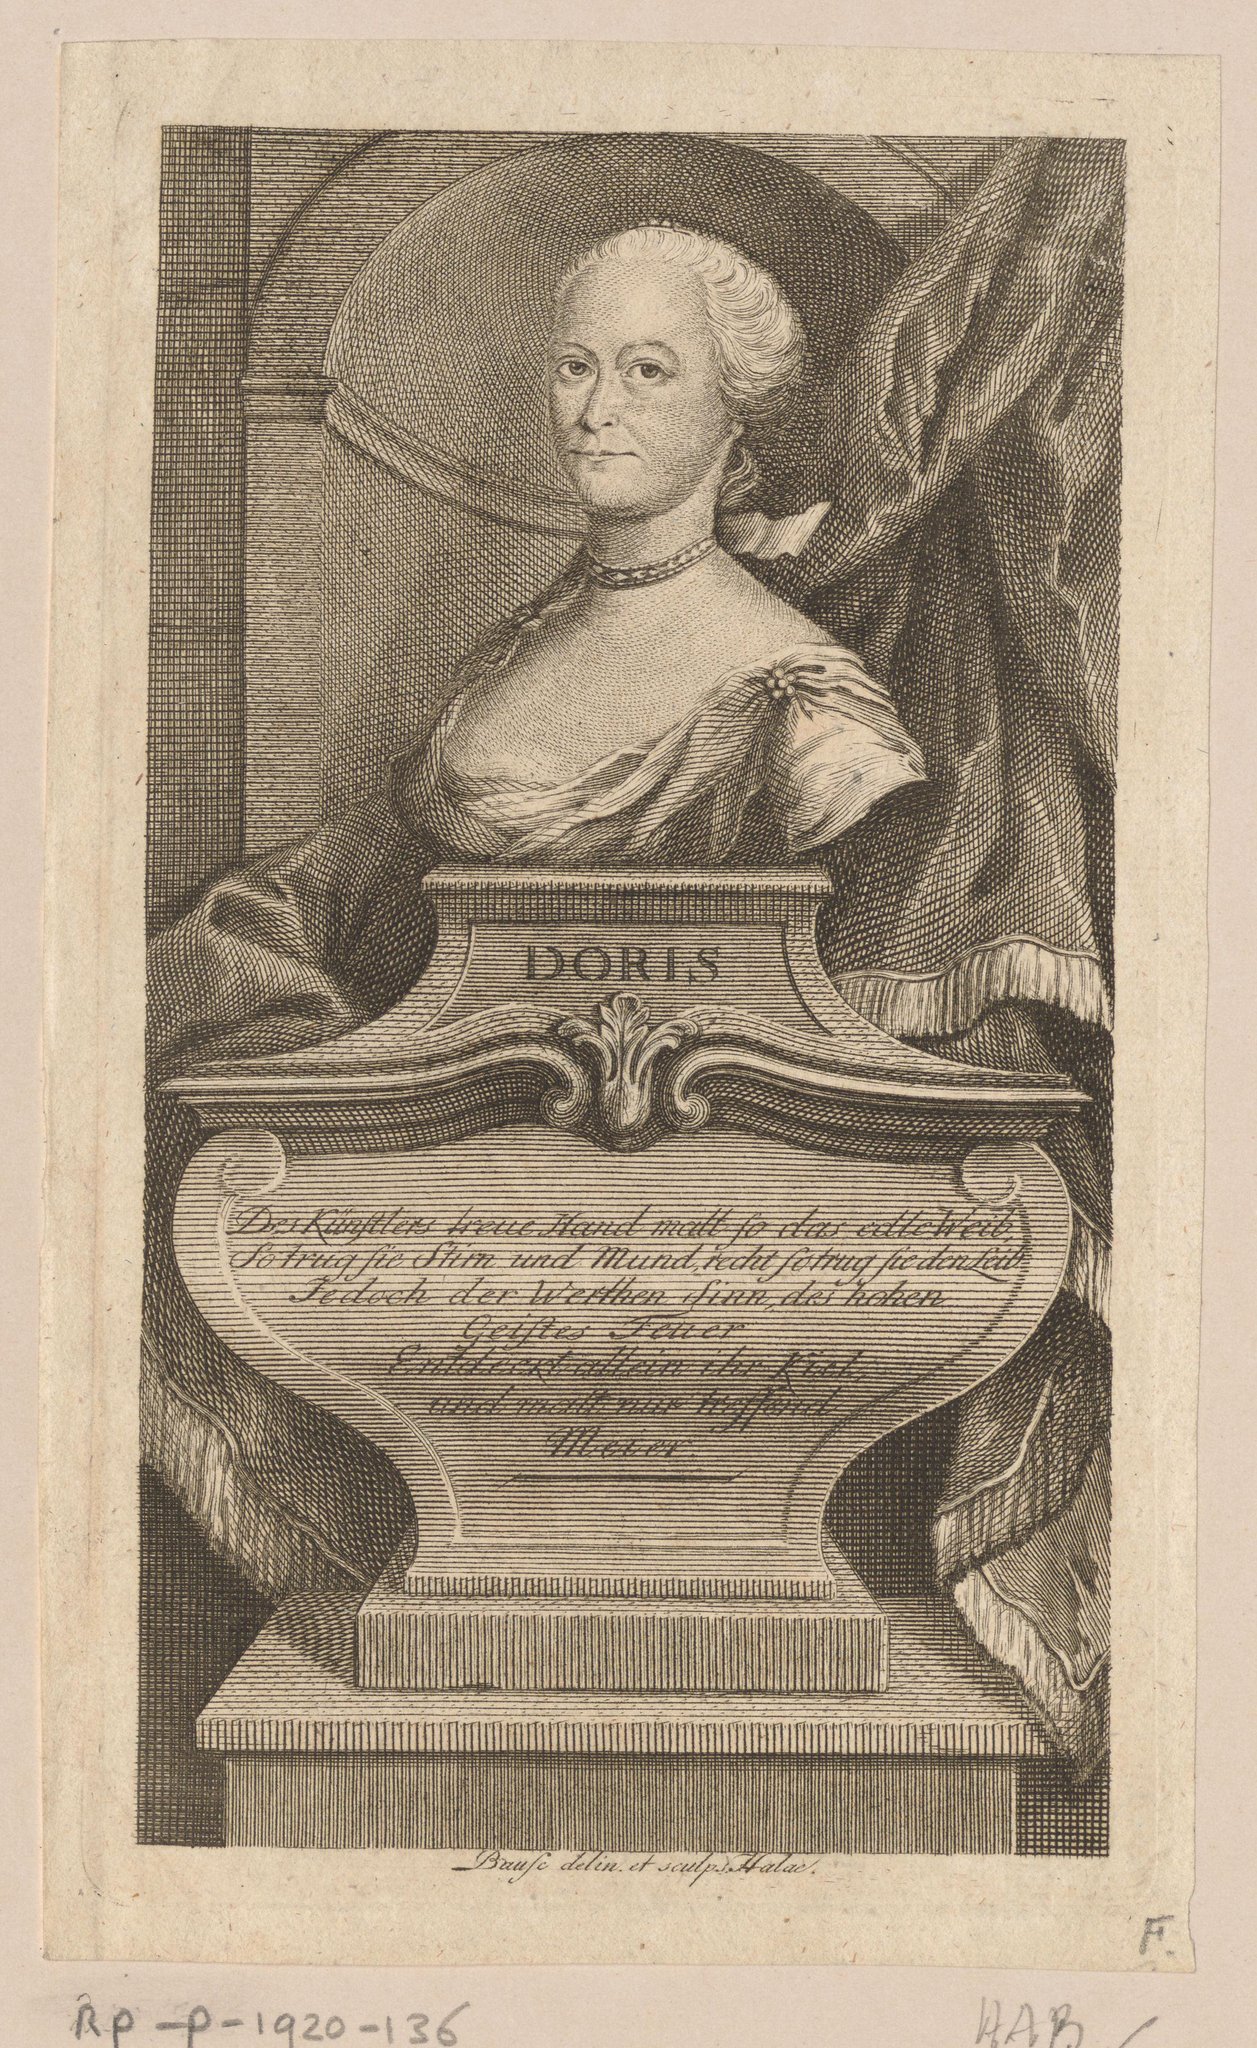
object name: print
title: Portretbuste van Anna Dorothea Lange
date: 1765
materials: paper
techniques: engraving, etching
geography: halle an der saale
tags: historical persons - bb - woman, portrait of a writer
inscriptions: collector's mark: Lugt 2228, collector's mark: Lugt 2710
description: Met vers in het Duits onder het portret.